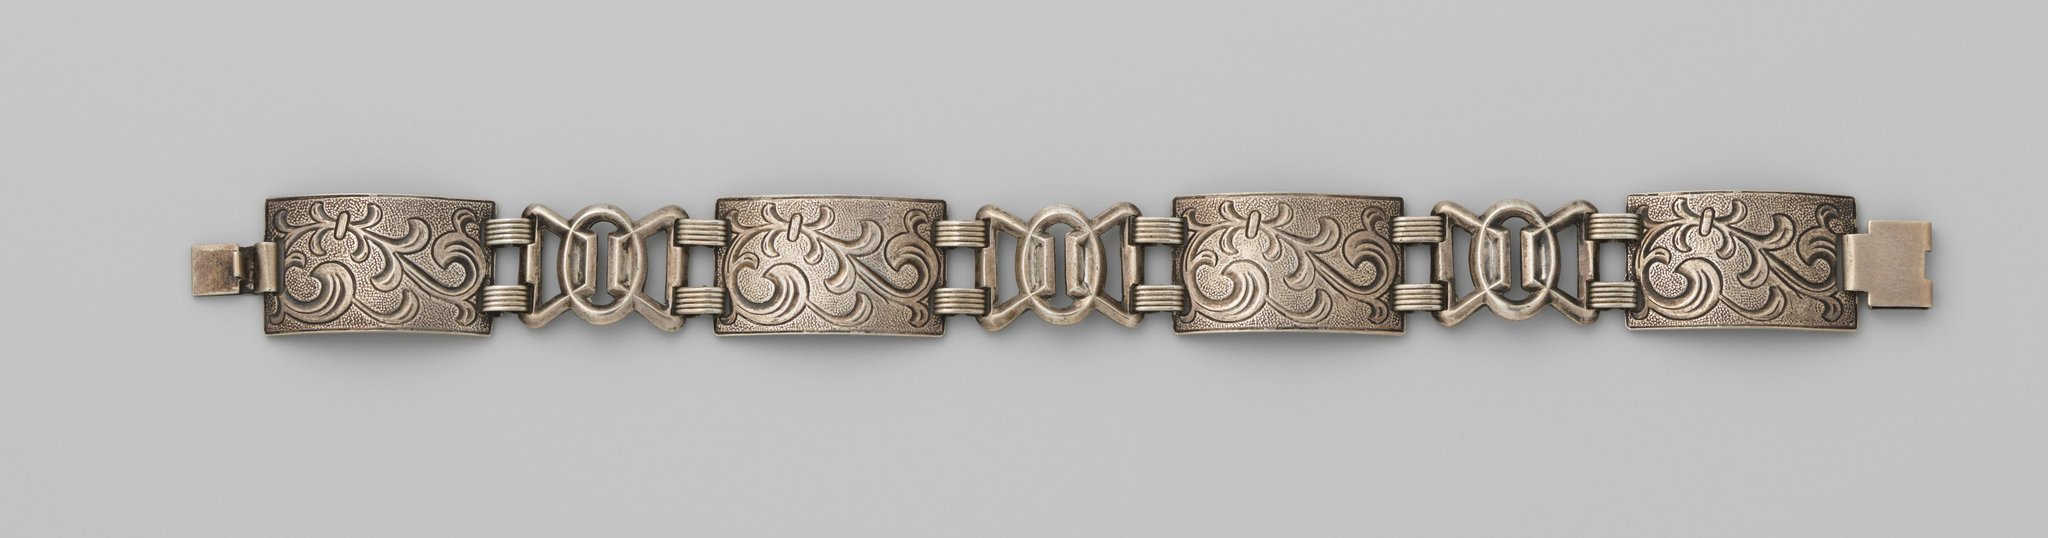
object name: bracelet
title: Armband van zilver met vier gegraveerde schakels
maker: j.b.h. van de puttelaar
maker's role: jeweler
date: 1950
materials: silver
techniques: engraving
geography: netherlands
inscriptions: maker's mark: ‘JB4P’, : ‘4’, alloy mark: ‘(oud) zwaard’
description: Armband van zilver met vier rechthoekige iets gebogen gegraveerde schakels verbonden door drie opengewerkte geometrische schakels voorzien van een baksluiting.